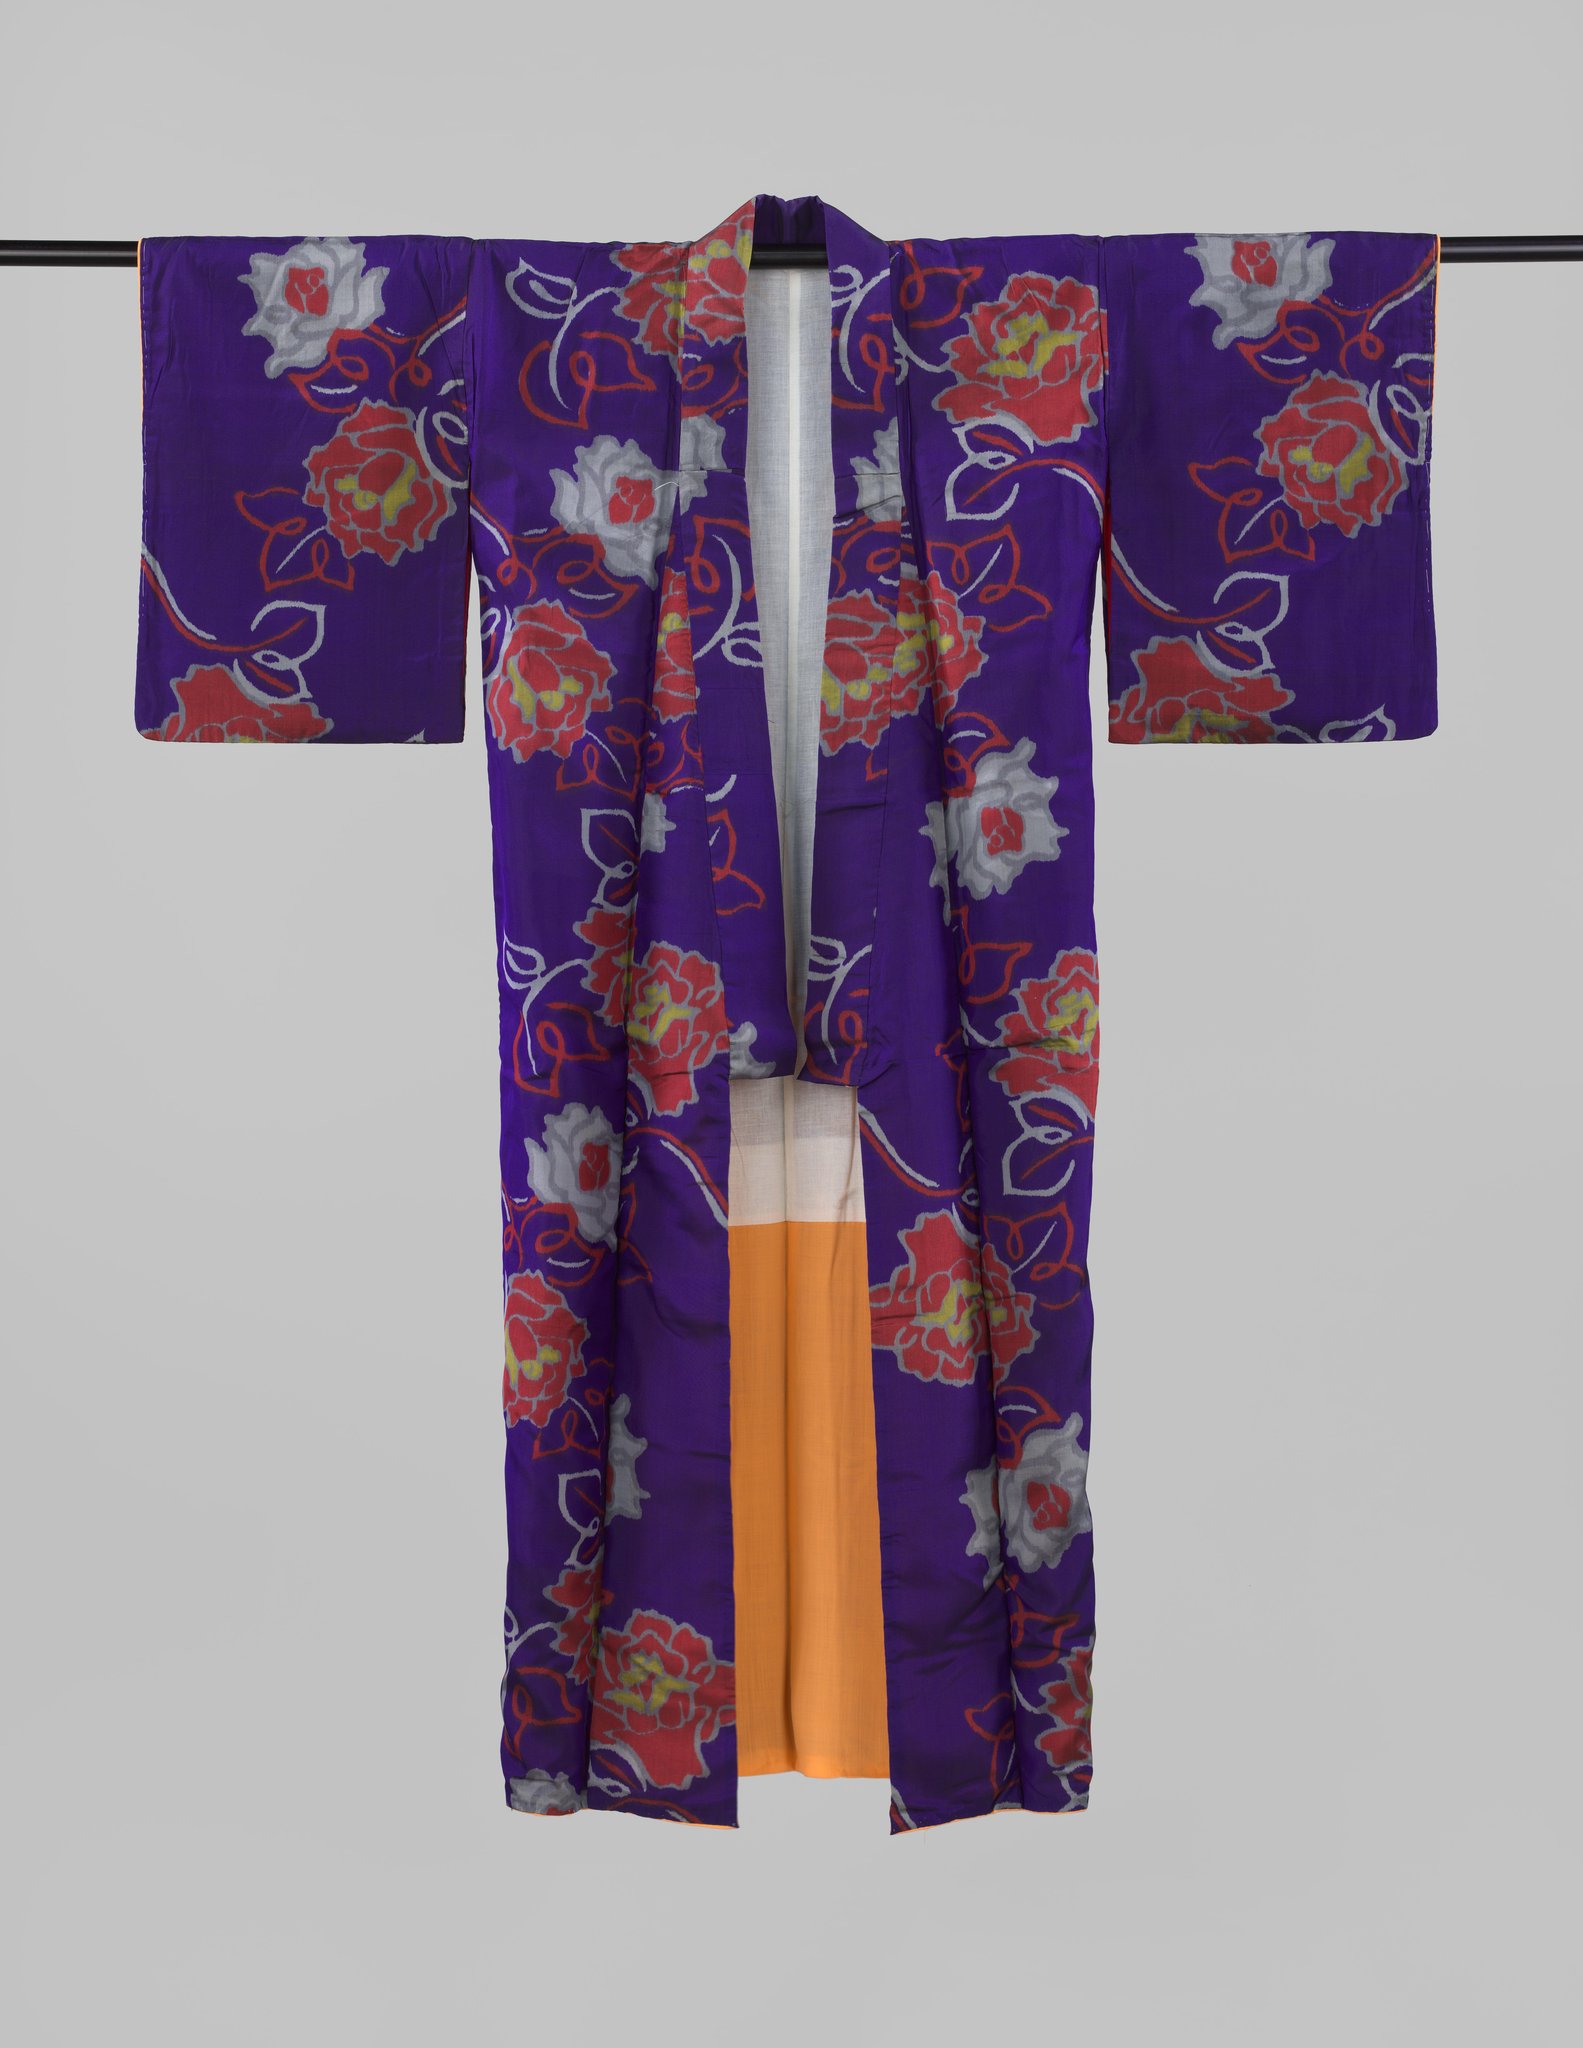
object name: kimono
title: Vrouwen kimono met rozen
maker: Anonymous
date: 1920-1940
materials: cotton, silk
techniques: painting, weave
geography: japan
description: Informele vrouwen kimono met een versiering over het hele vlak van grote rozen. Paarse zijde met versiering in stencil-druk (meisen) in rood, geel en wit. Voering van witteen oranje katoen.